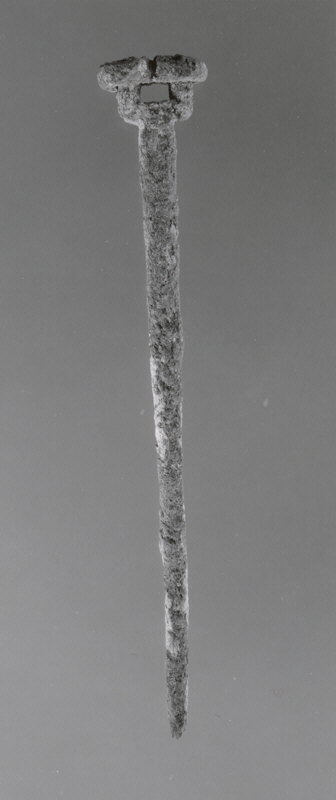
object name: pin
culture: bactria-margiana archaeological complex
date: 2333-1668 BCE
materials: copper alloy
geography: bactria-margiana